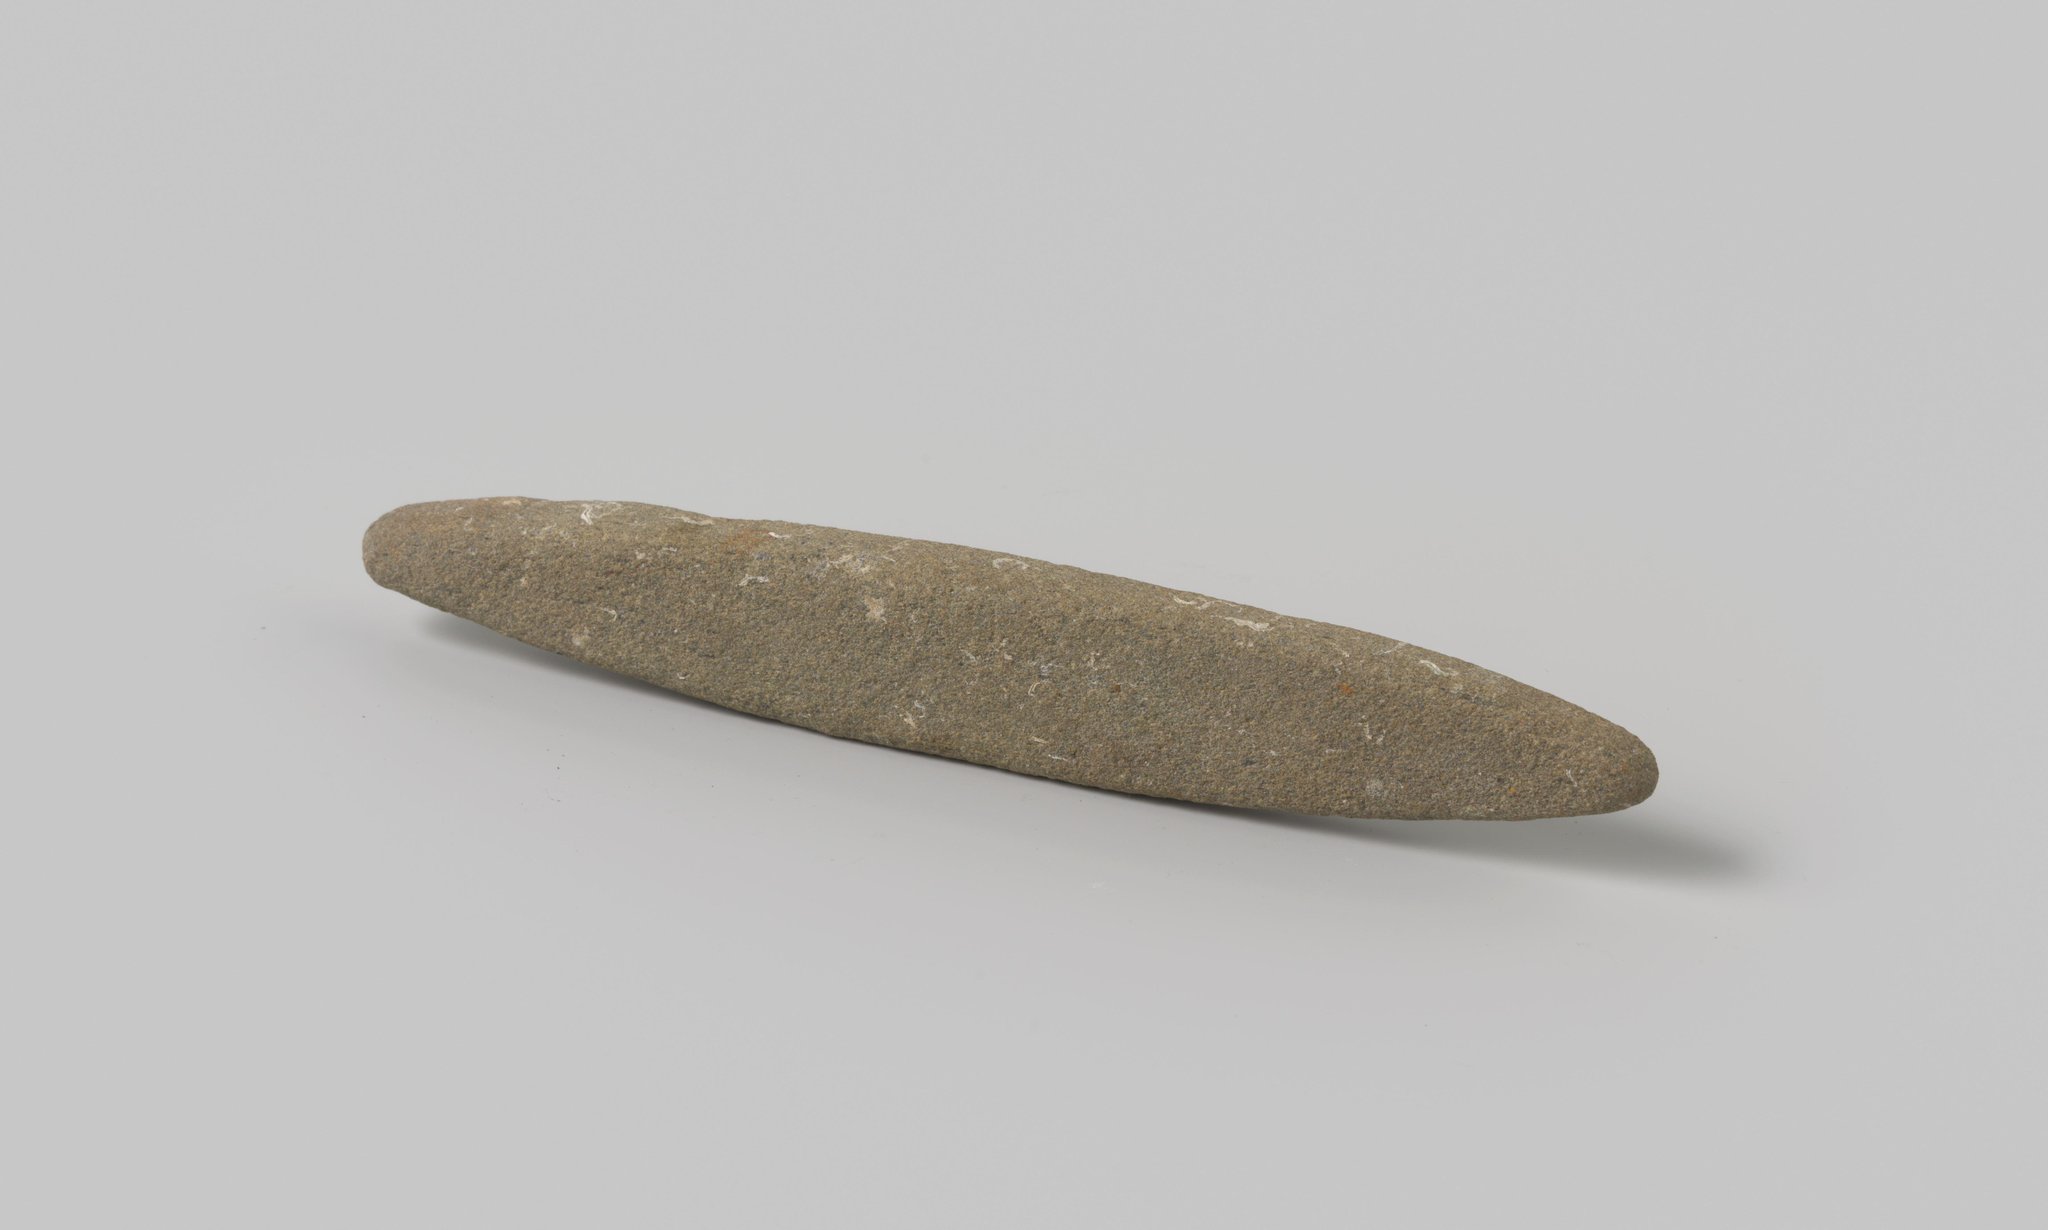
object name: whetstone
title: Slijpsteen uit het wrak van de Oost-Indiëvaarder Hollandia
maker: Anonymous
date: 1700-1743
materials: stone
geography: netherlands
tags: verenigde oostindische compagnie, hollandia (schip), annet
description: Hone; flat, rounded corners, tapering pointed ends.